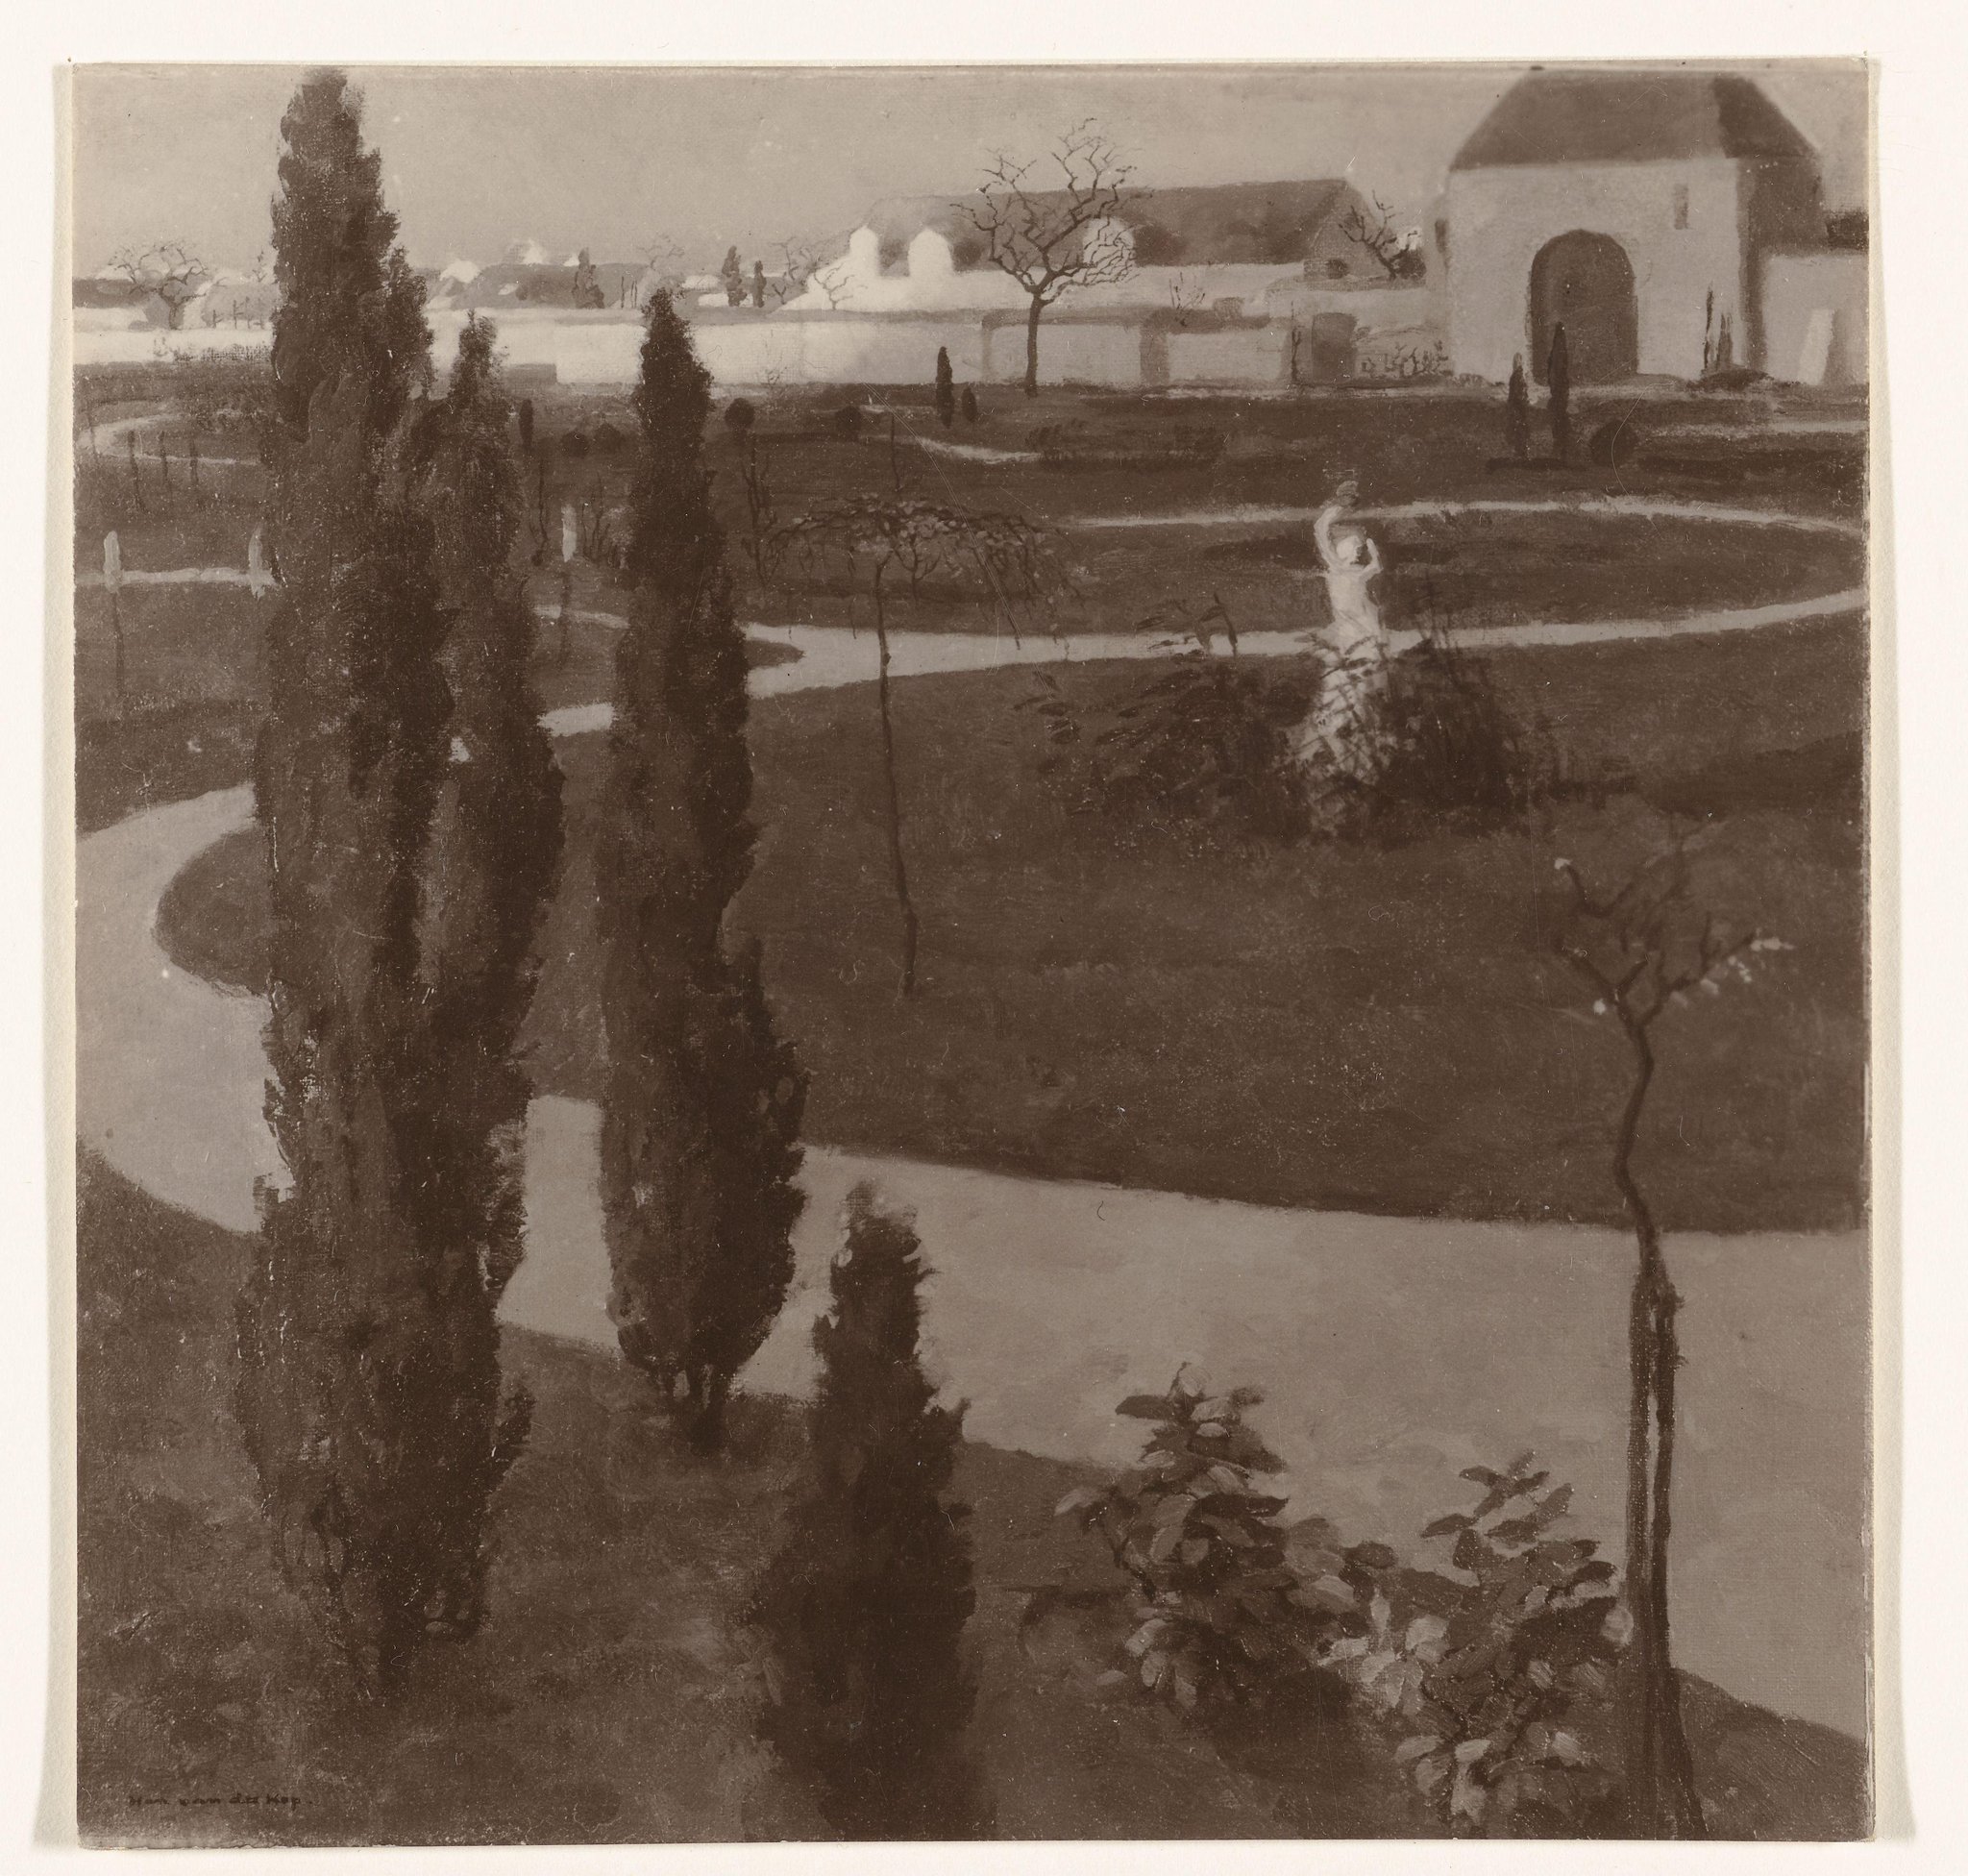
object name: photograph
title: Fotoreproductie van een schilderij (landschap) door Han van der Kop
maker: adriaan bijl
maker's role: fotograaf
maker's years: 1874-1967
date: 1933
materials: paper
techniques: gelatin silver print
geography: amsterdam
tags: picture, painting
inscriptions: signature: ‘ADR. Bijl - Hoofdweg 78 Amsterdam’, annotation: ‘Reproductie van nagelaten werk van Han van der Kop’